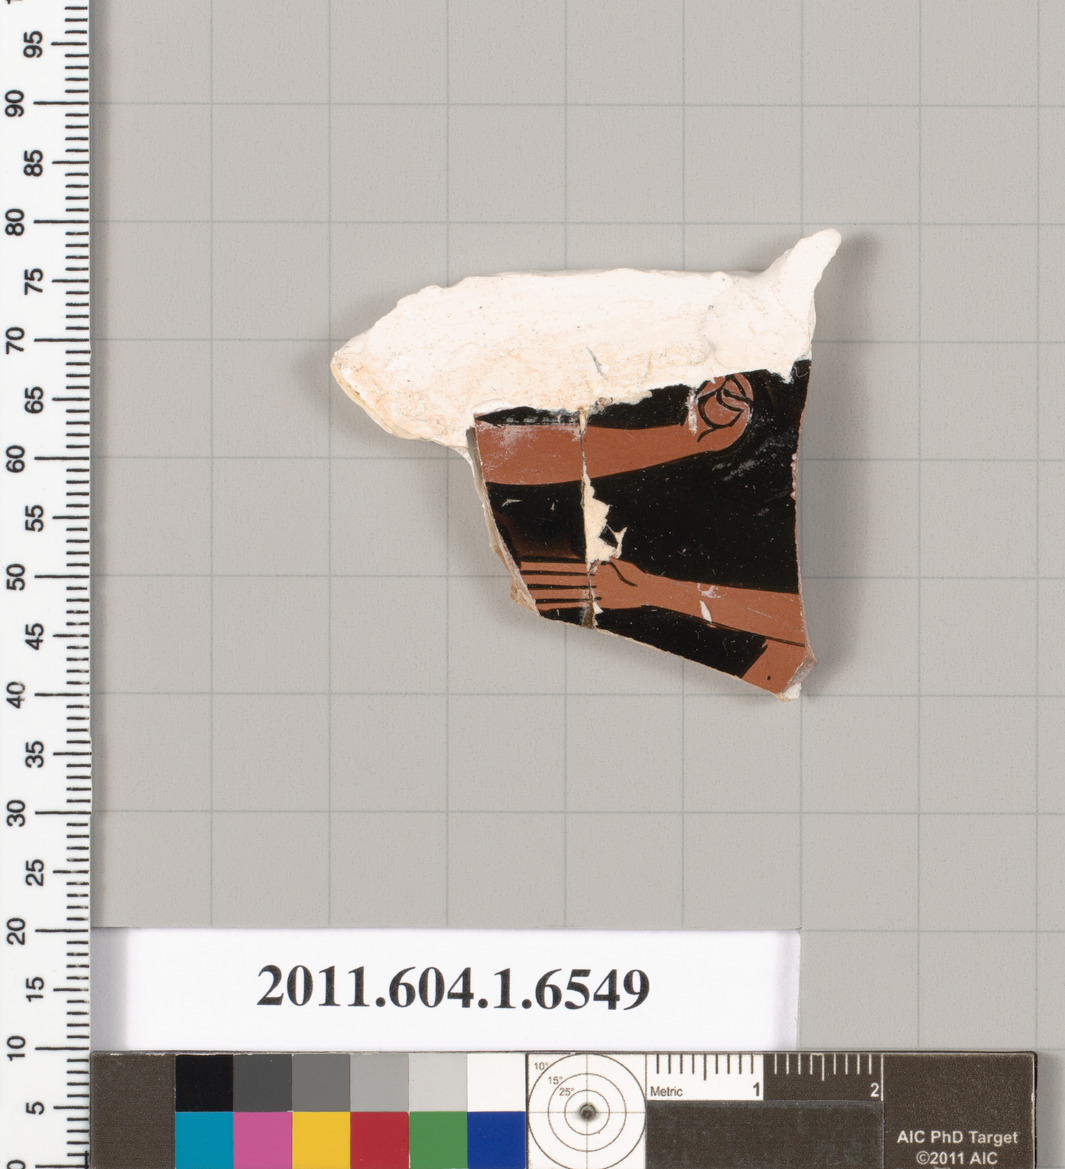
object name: kylix fragment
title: Terracotta fragment of a kylix (drinking cup)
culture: greek, attic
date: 490-480 BCE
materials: terracotta